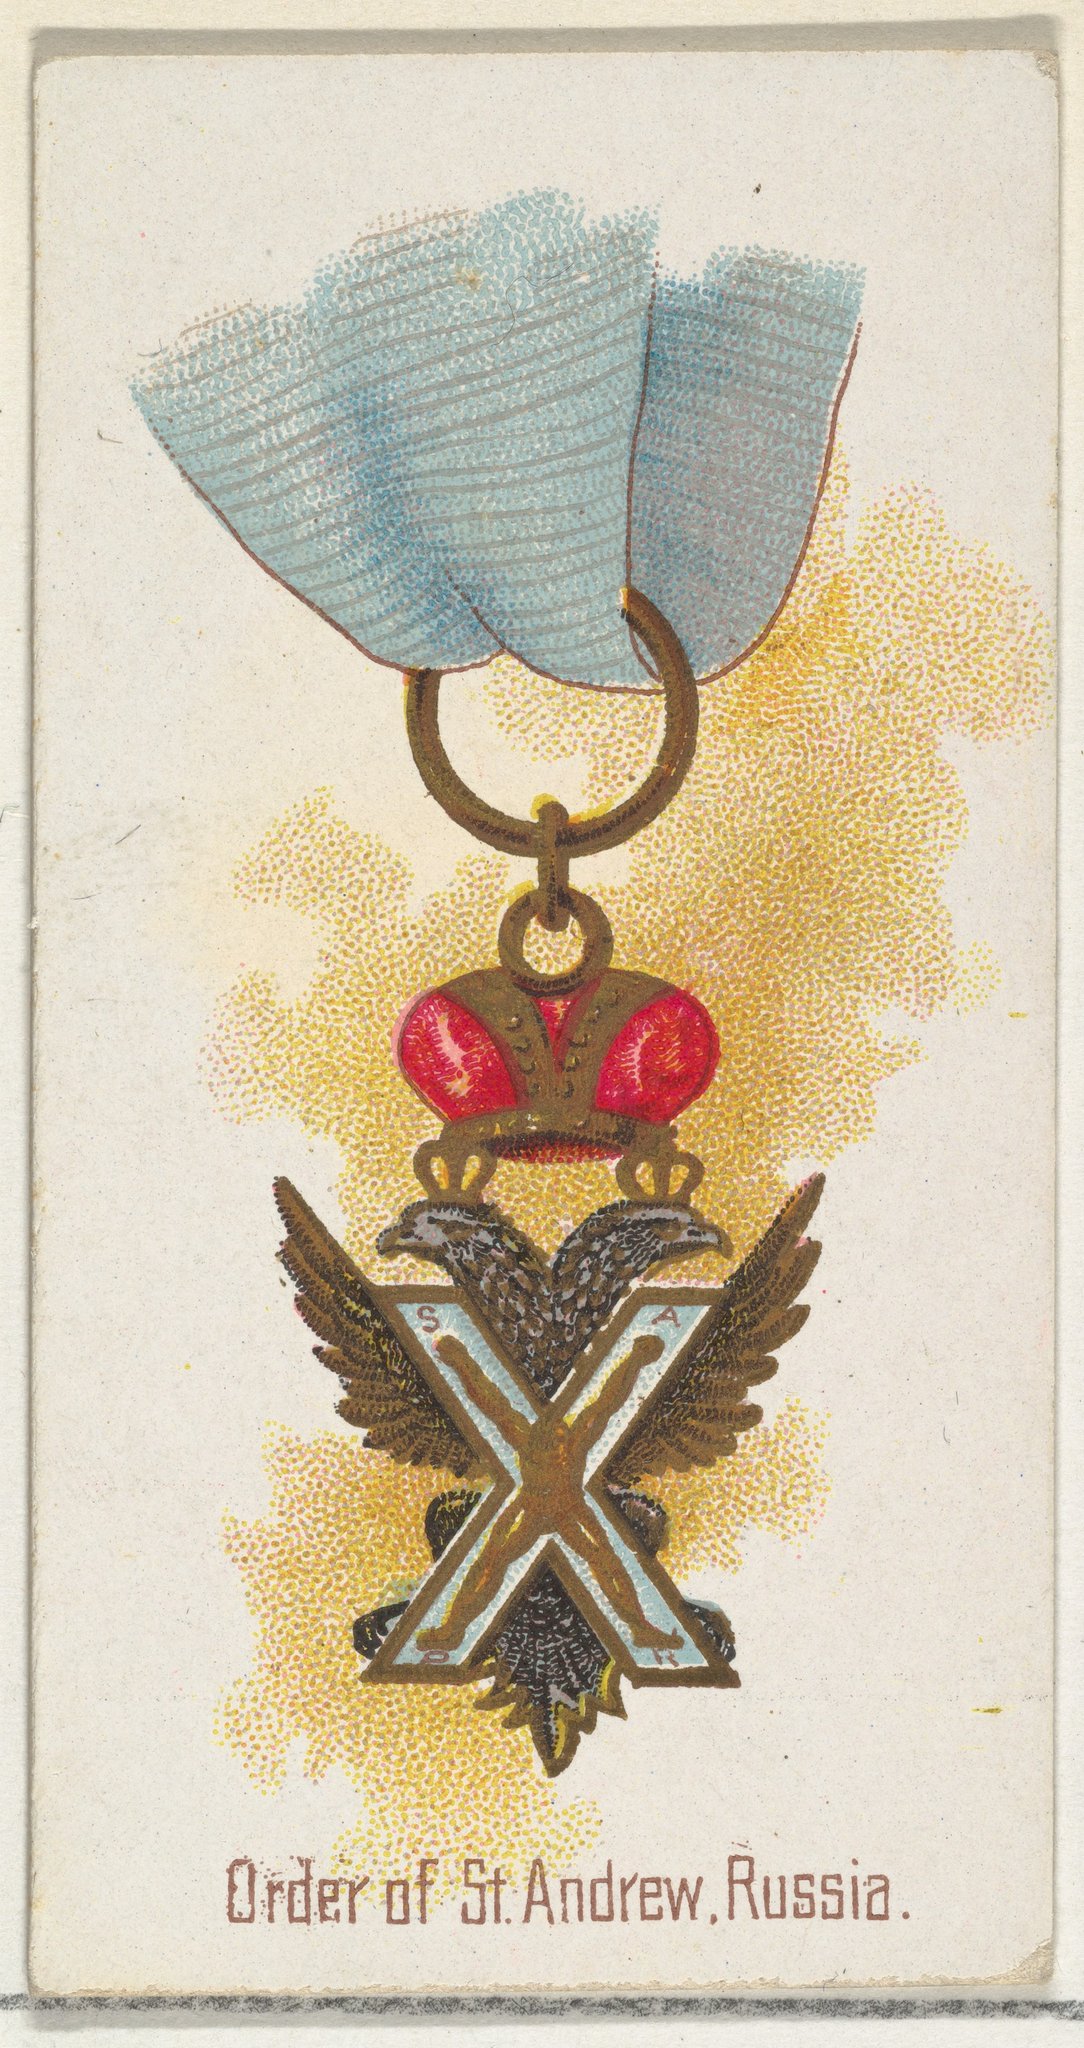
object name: print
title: Order of St. Andrew, Russia, from the World's Decorations series (N30) for Allen & Ginter Cigarettes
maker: allen & ginter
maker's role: publisher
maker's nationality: american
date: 1890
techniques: color lithograph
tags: medals